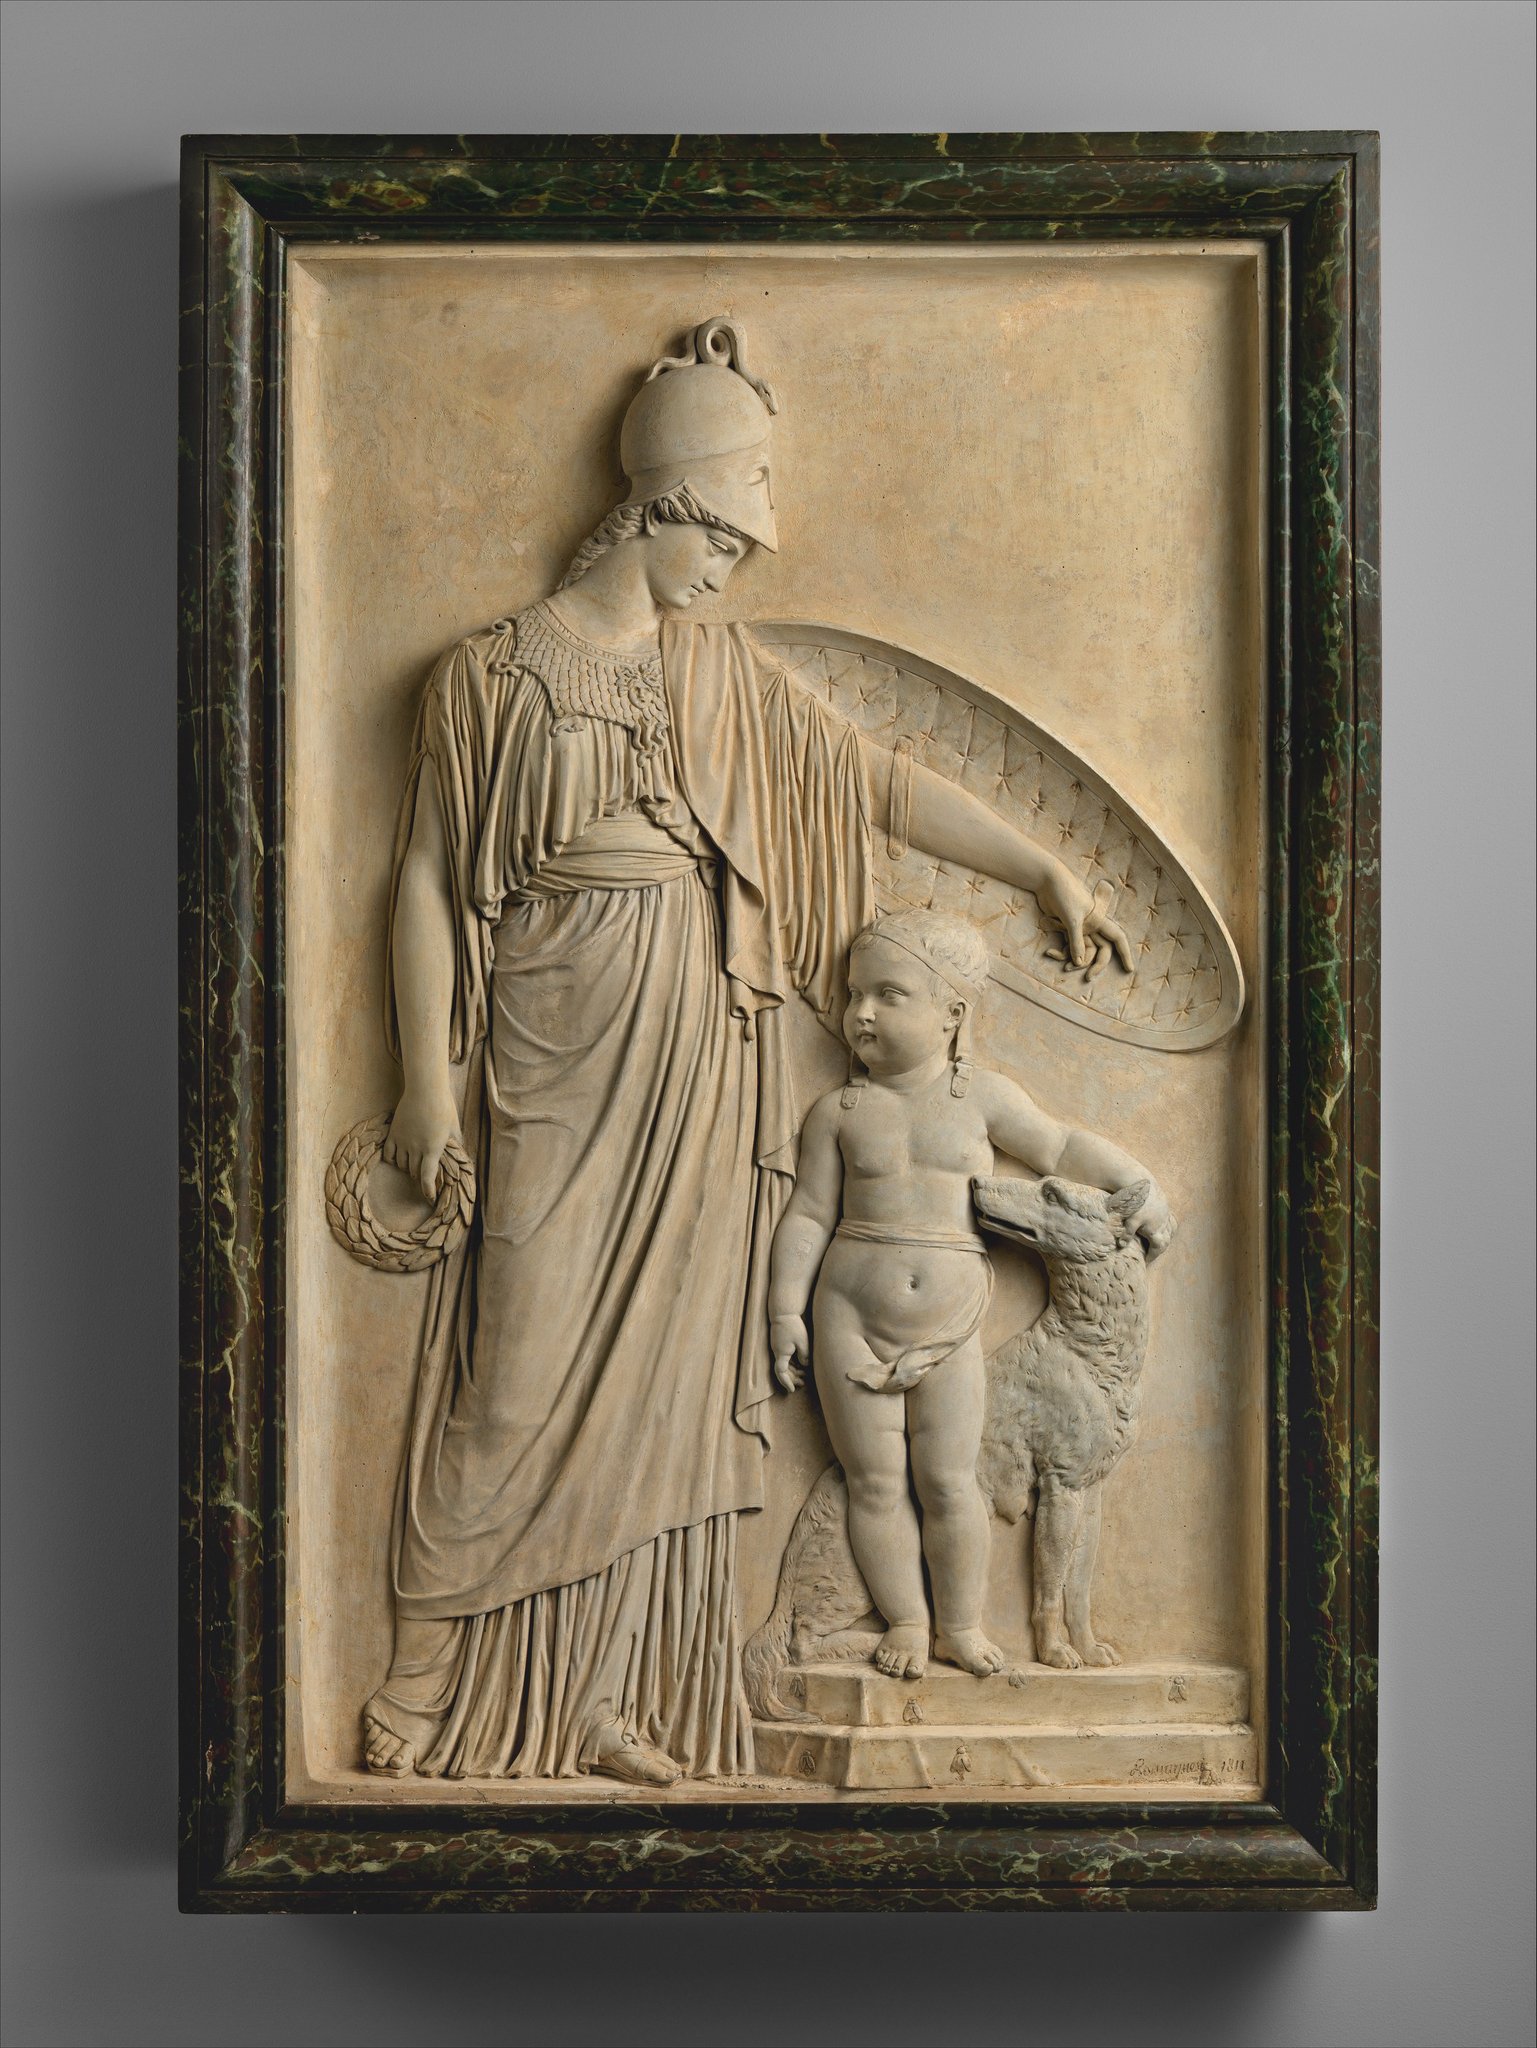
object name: relief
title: Minerva Protecting the Young King of Rome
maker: joseph-antoine romagnési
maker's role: artist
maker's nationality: french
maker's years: 1782-1852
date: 1811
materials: plaster, stone, wood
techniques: painting, relief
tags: helmets,shields,kings,minerva,dogs,wreaths